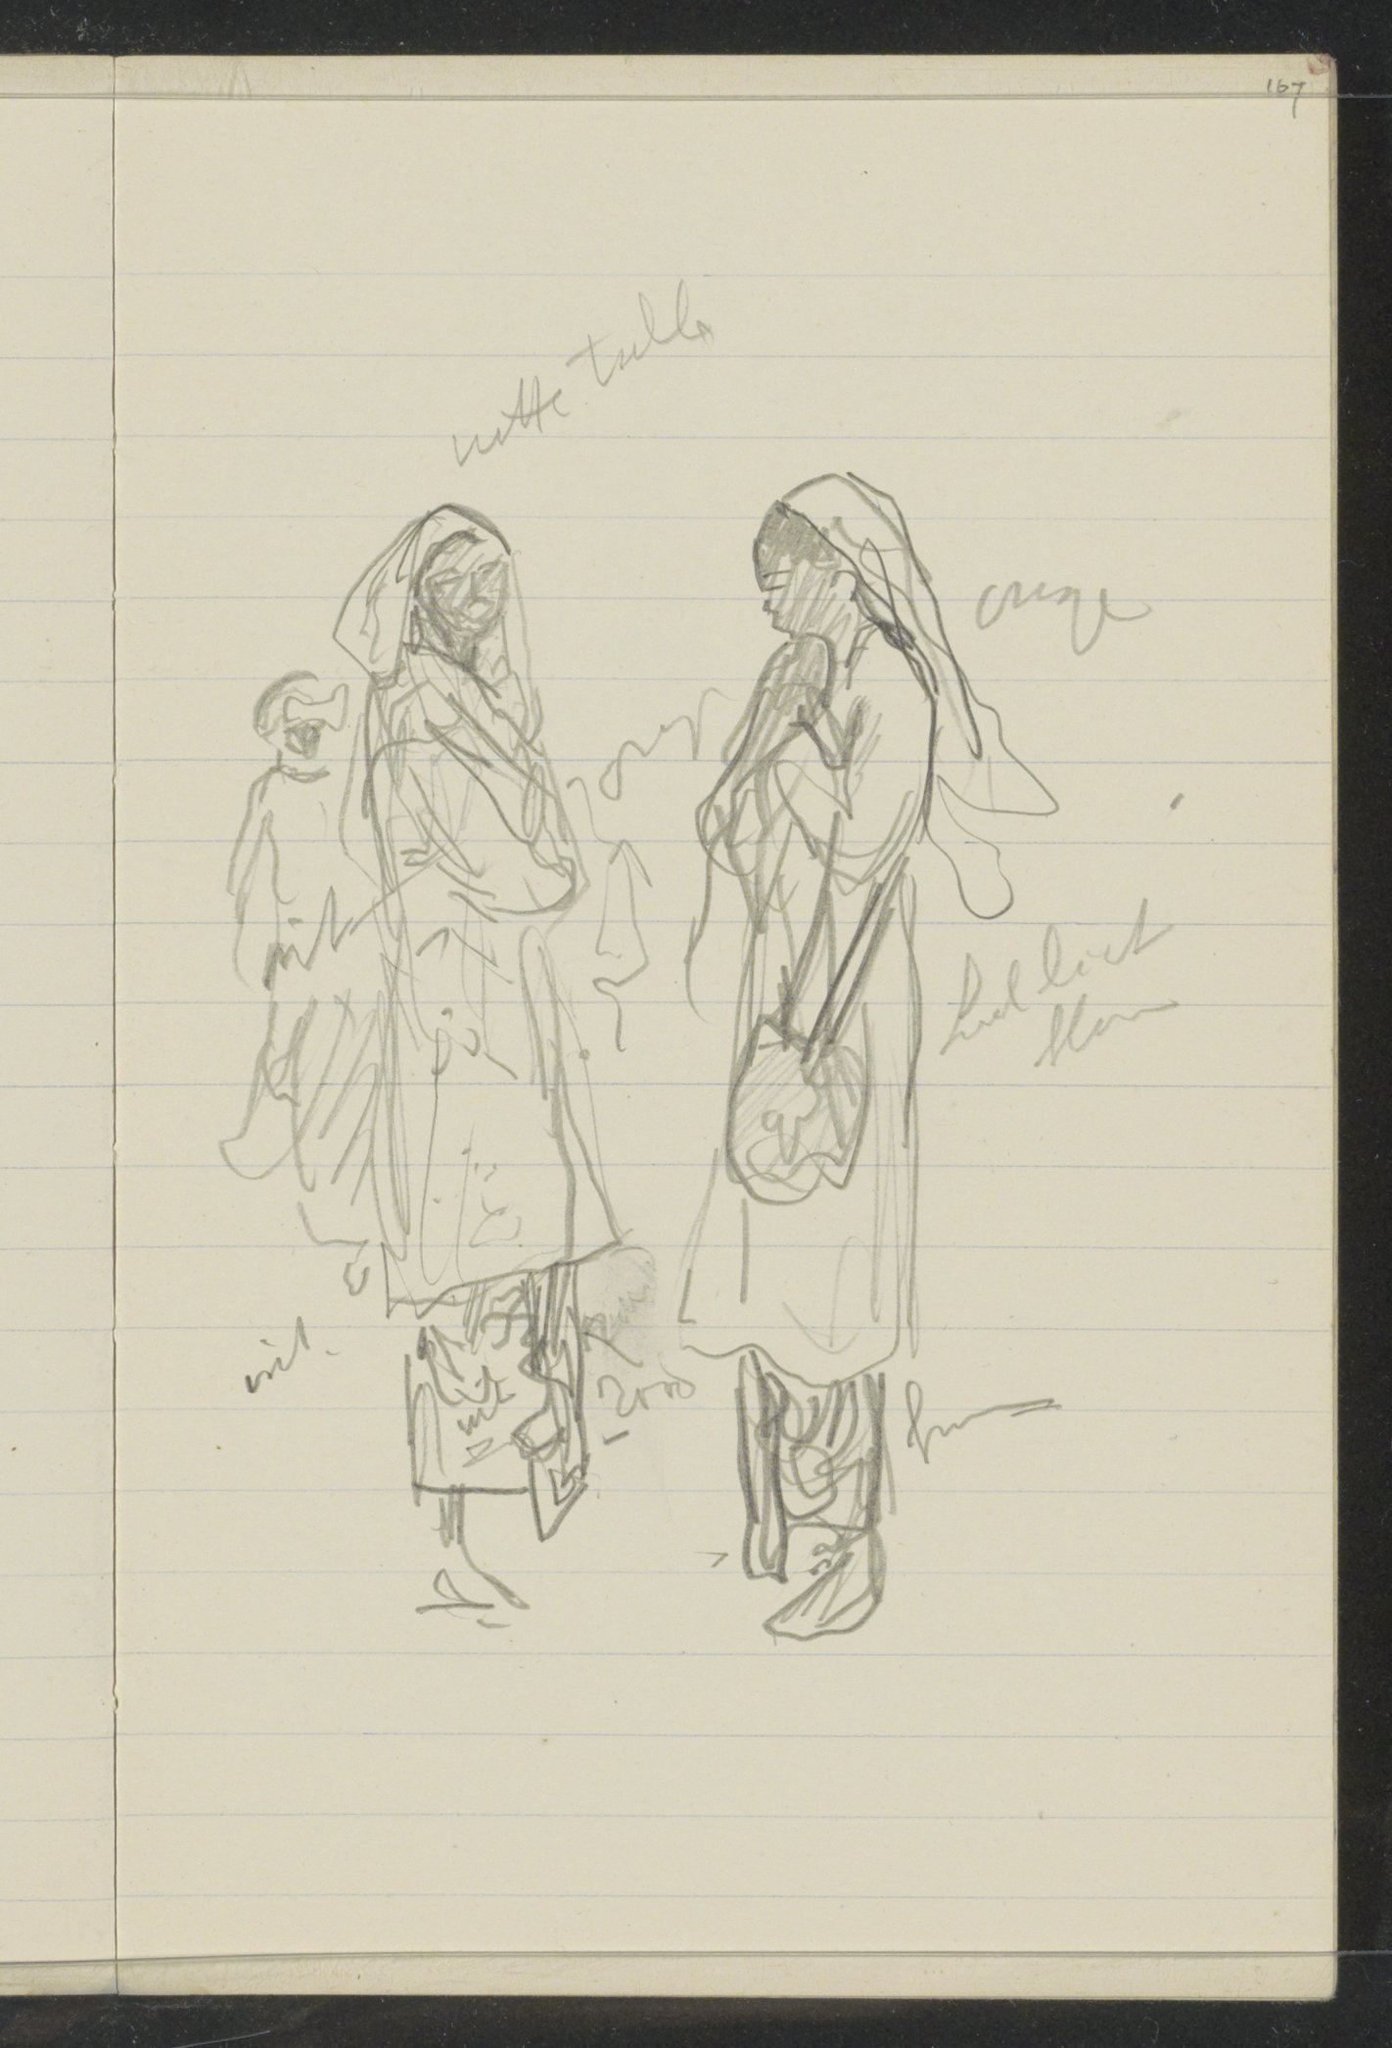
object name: sketchbook leaf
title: Indonesische vrouwen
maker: marius bauer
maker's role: draughtsman, print maker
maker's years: 1867-1932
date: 1931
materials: pencil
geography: indonesia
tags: asiatic races and peoples, adult woman, folk costume, regional costume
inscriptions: kleurnotitie, handgeschreven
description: De vrouwen dragen traditioneel kostuum. Pagina 107 uit een schetsboek met 74 bladen.